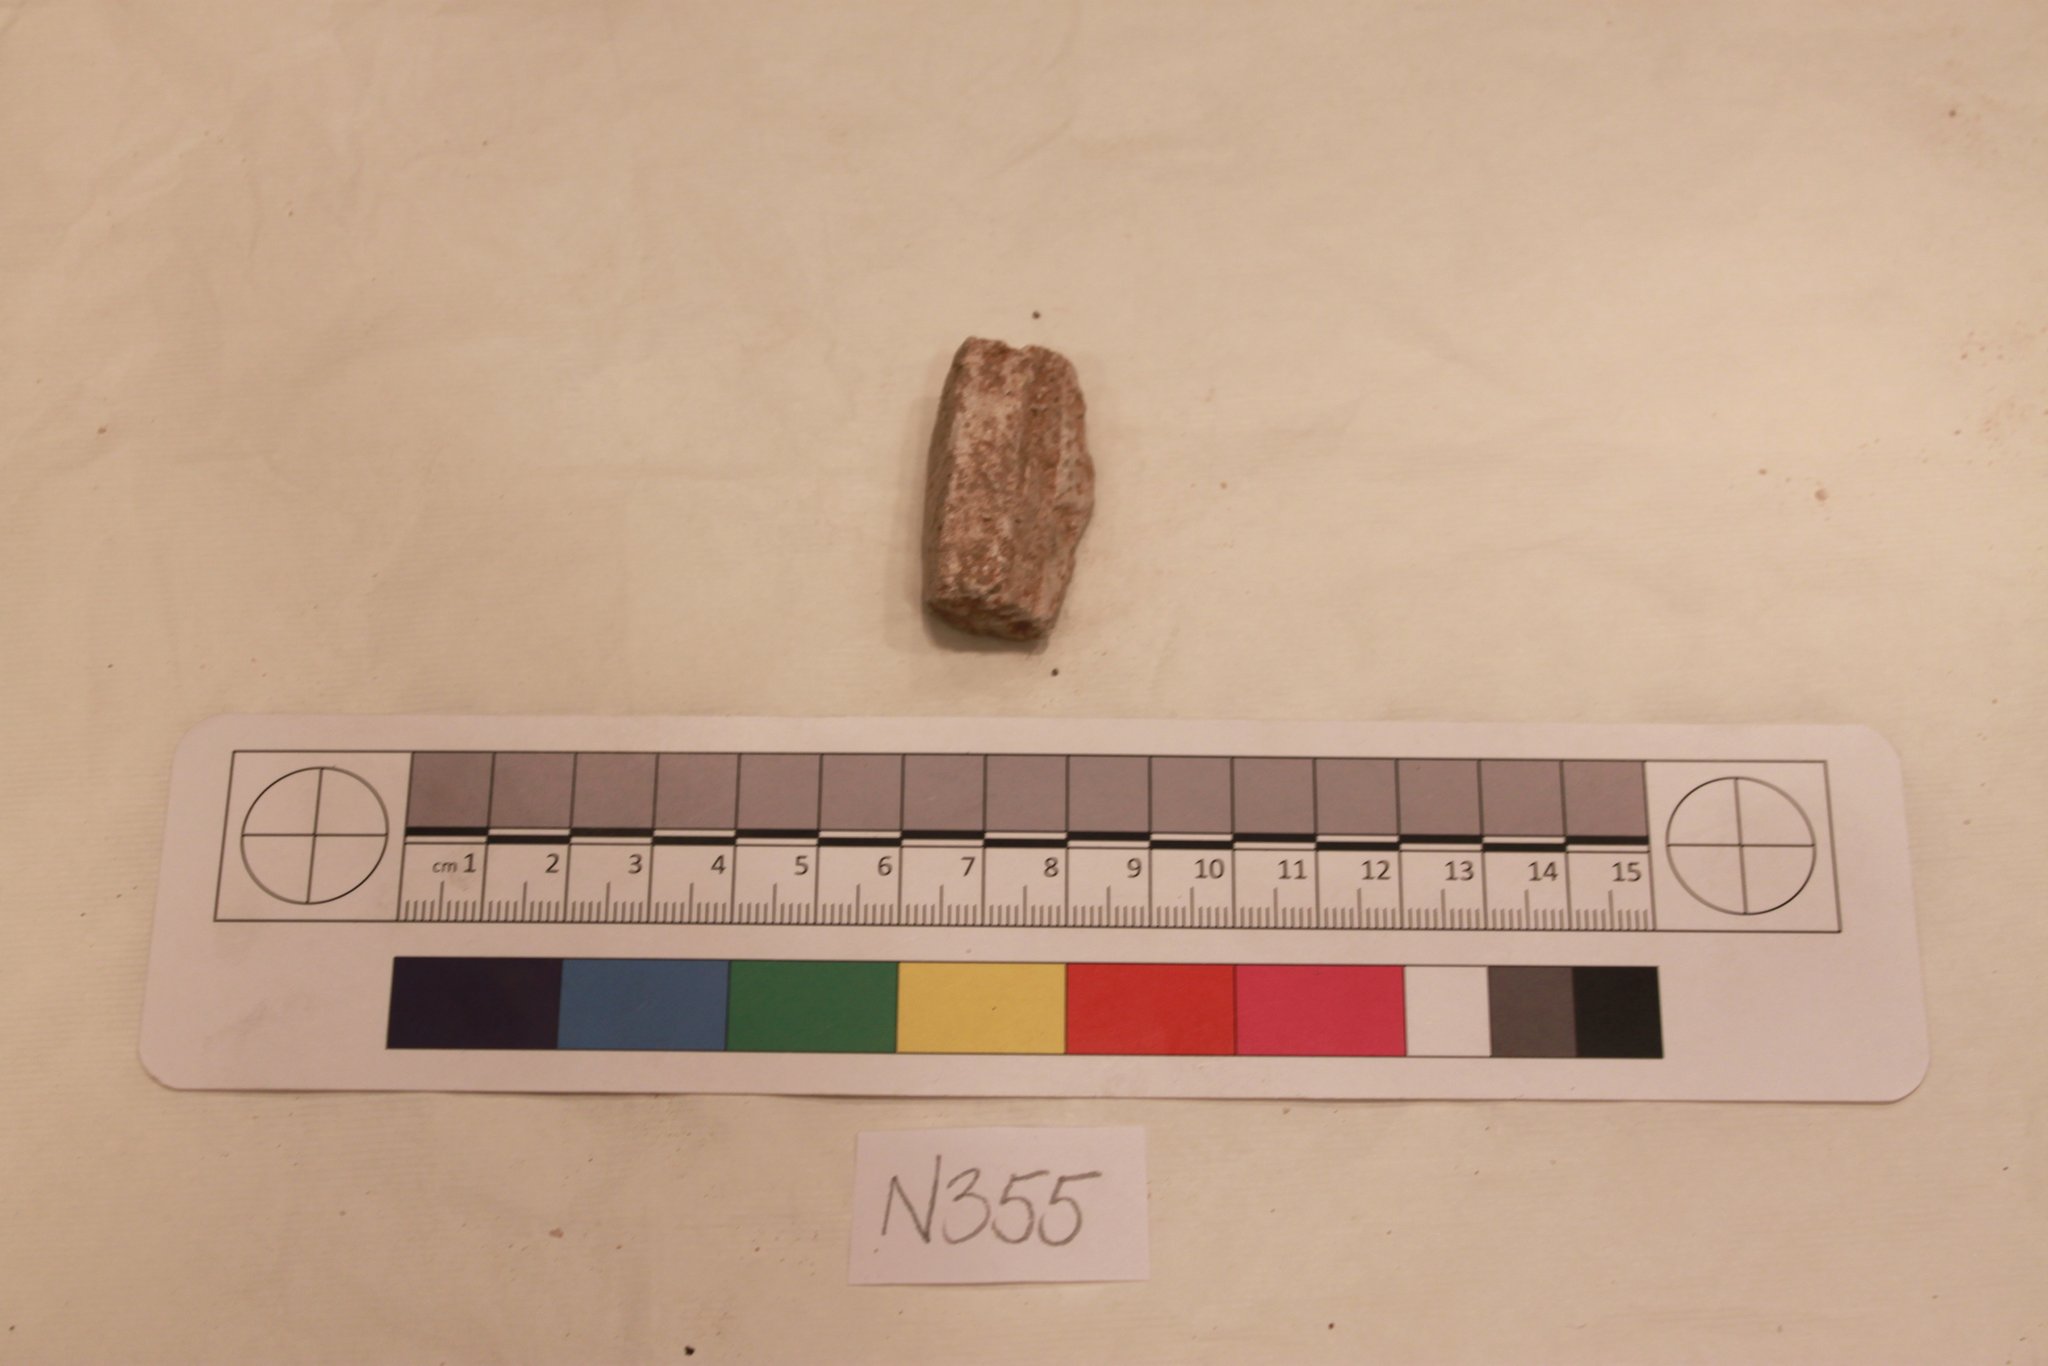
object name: fragment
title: Stucco Fragment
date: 701-1200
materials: plaster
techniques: carving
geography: iran